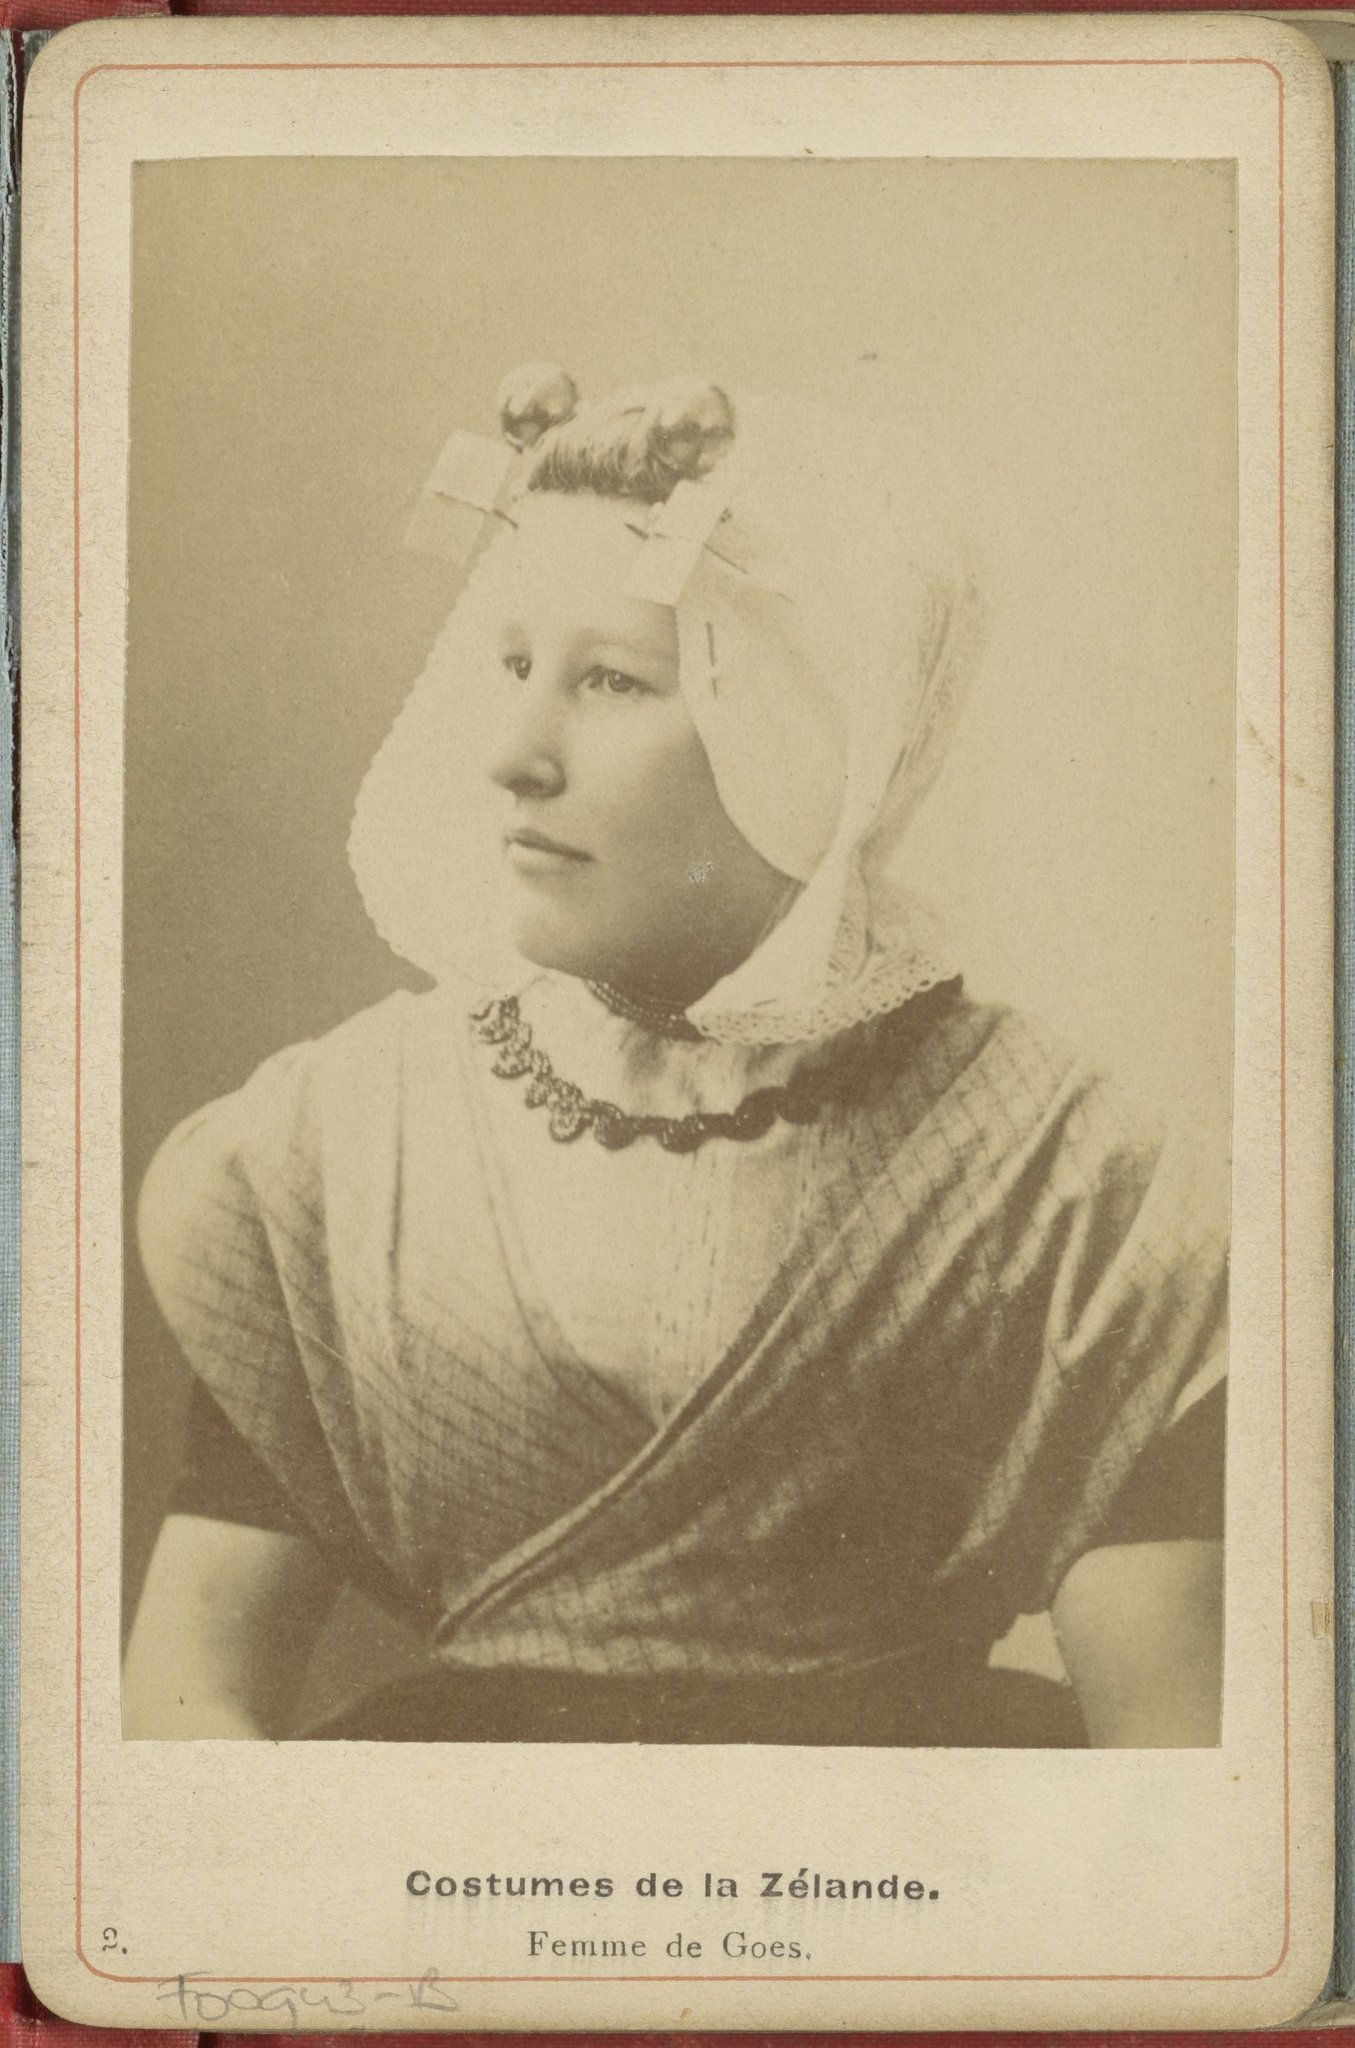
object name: photograph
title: Vrouw in de klederdracht van Goes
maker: Anonymous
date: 1870-1910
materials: cardboard, photographic support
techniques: albumen print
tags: folk costume, regional costume (+ women's clothes)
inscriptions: number: ‘2’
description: Onderdeel van Leporelloalbum met Zeeuwse klederdrachten.